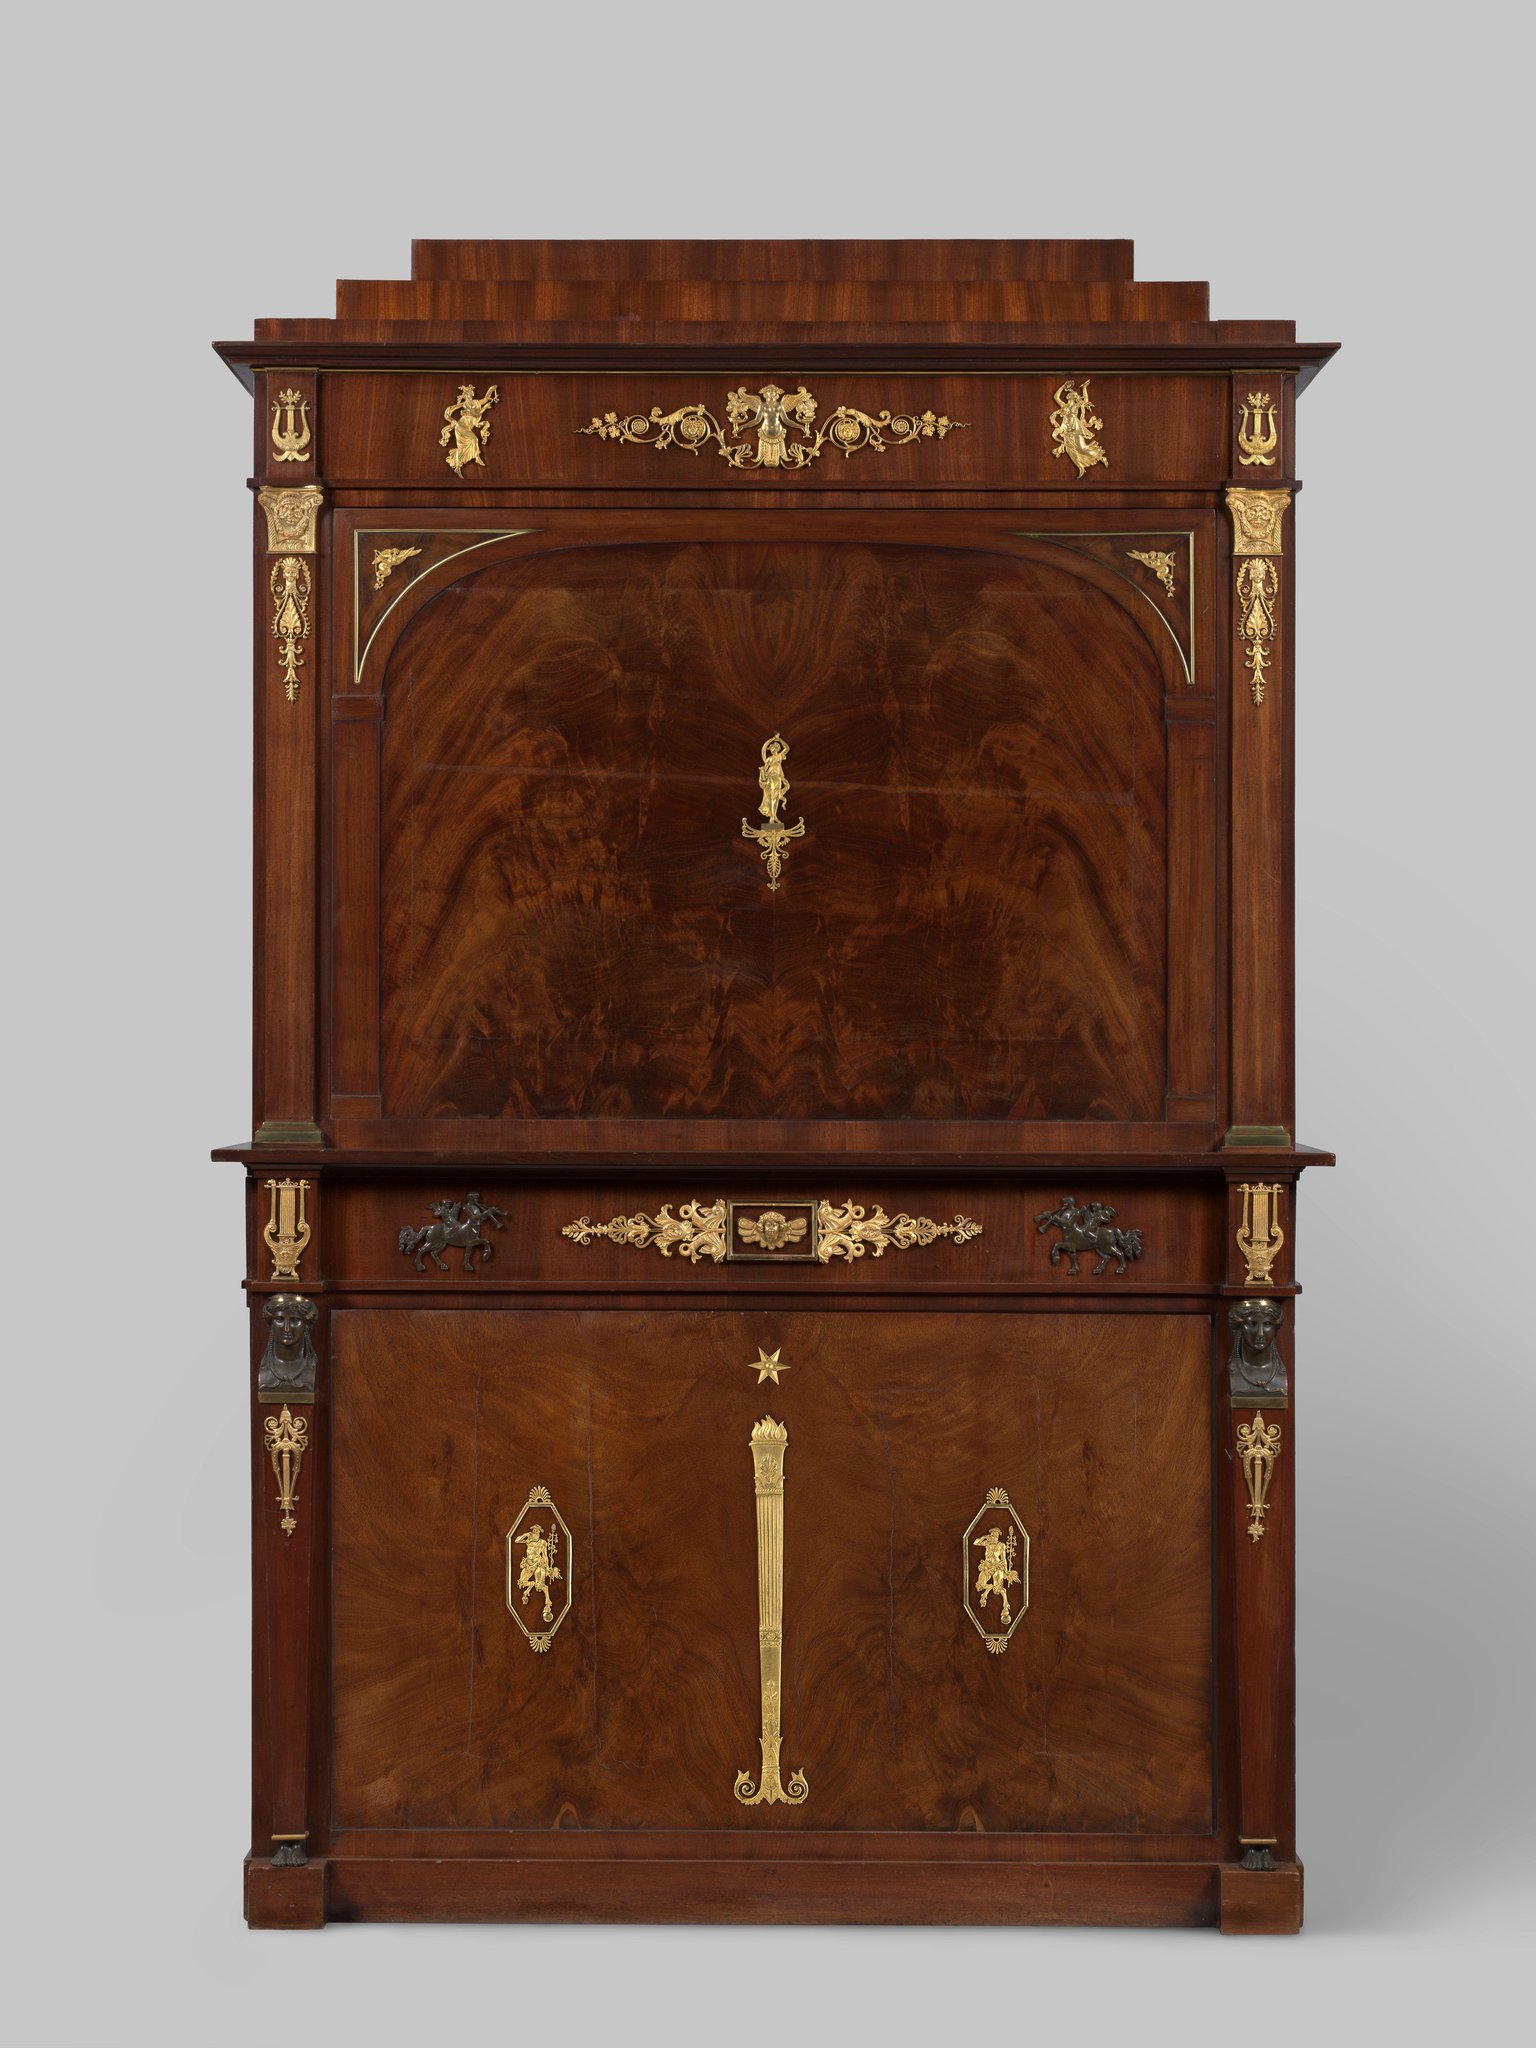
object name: musical instrument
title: Orchestrion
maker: dietrich nikolaus winkel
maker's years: 1777-1826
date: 1815-1825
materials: copper, wood, marble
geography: amsterdam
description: Mechanisch orgel in de vorm van een secretaire, van eiken en mahonie (de kleppen van bloemplaat), de zijvakken bekleed met groen saaikleppen, friezen en stijlen versierd met koperen figuren en ornament in klassieke stijl: pansfiguurtjes, centauren, dansende vrouwenfiguren, meerminnen, maskers. Trapbekroning met wit marmeren blad. Van binnen: twee rollen en een slinger. Gemerkt: D.N. WINKEL à Amsterdam. Bijbehorend rollenkastje BK-NM-14353-B.